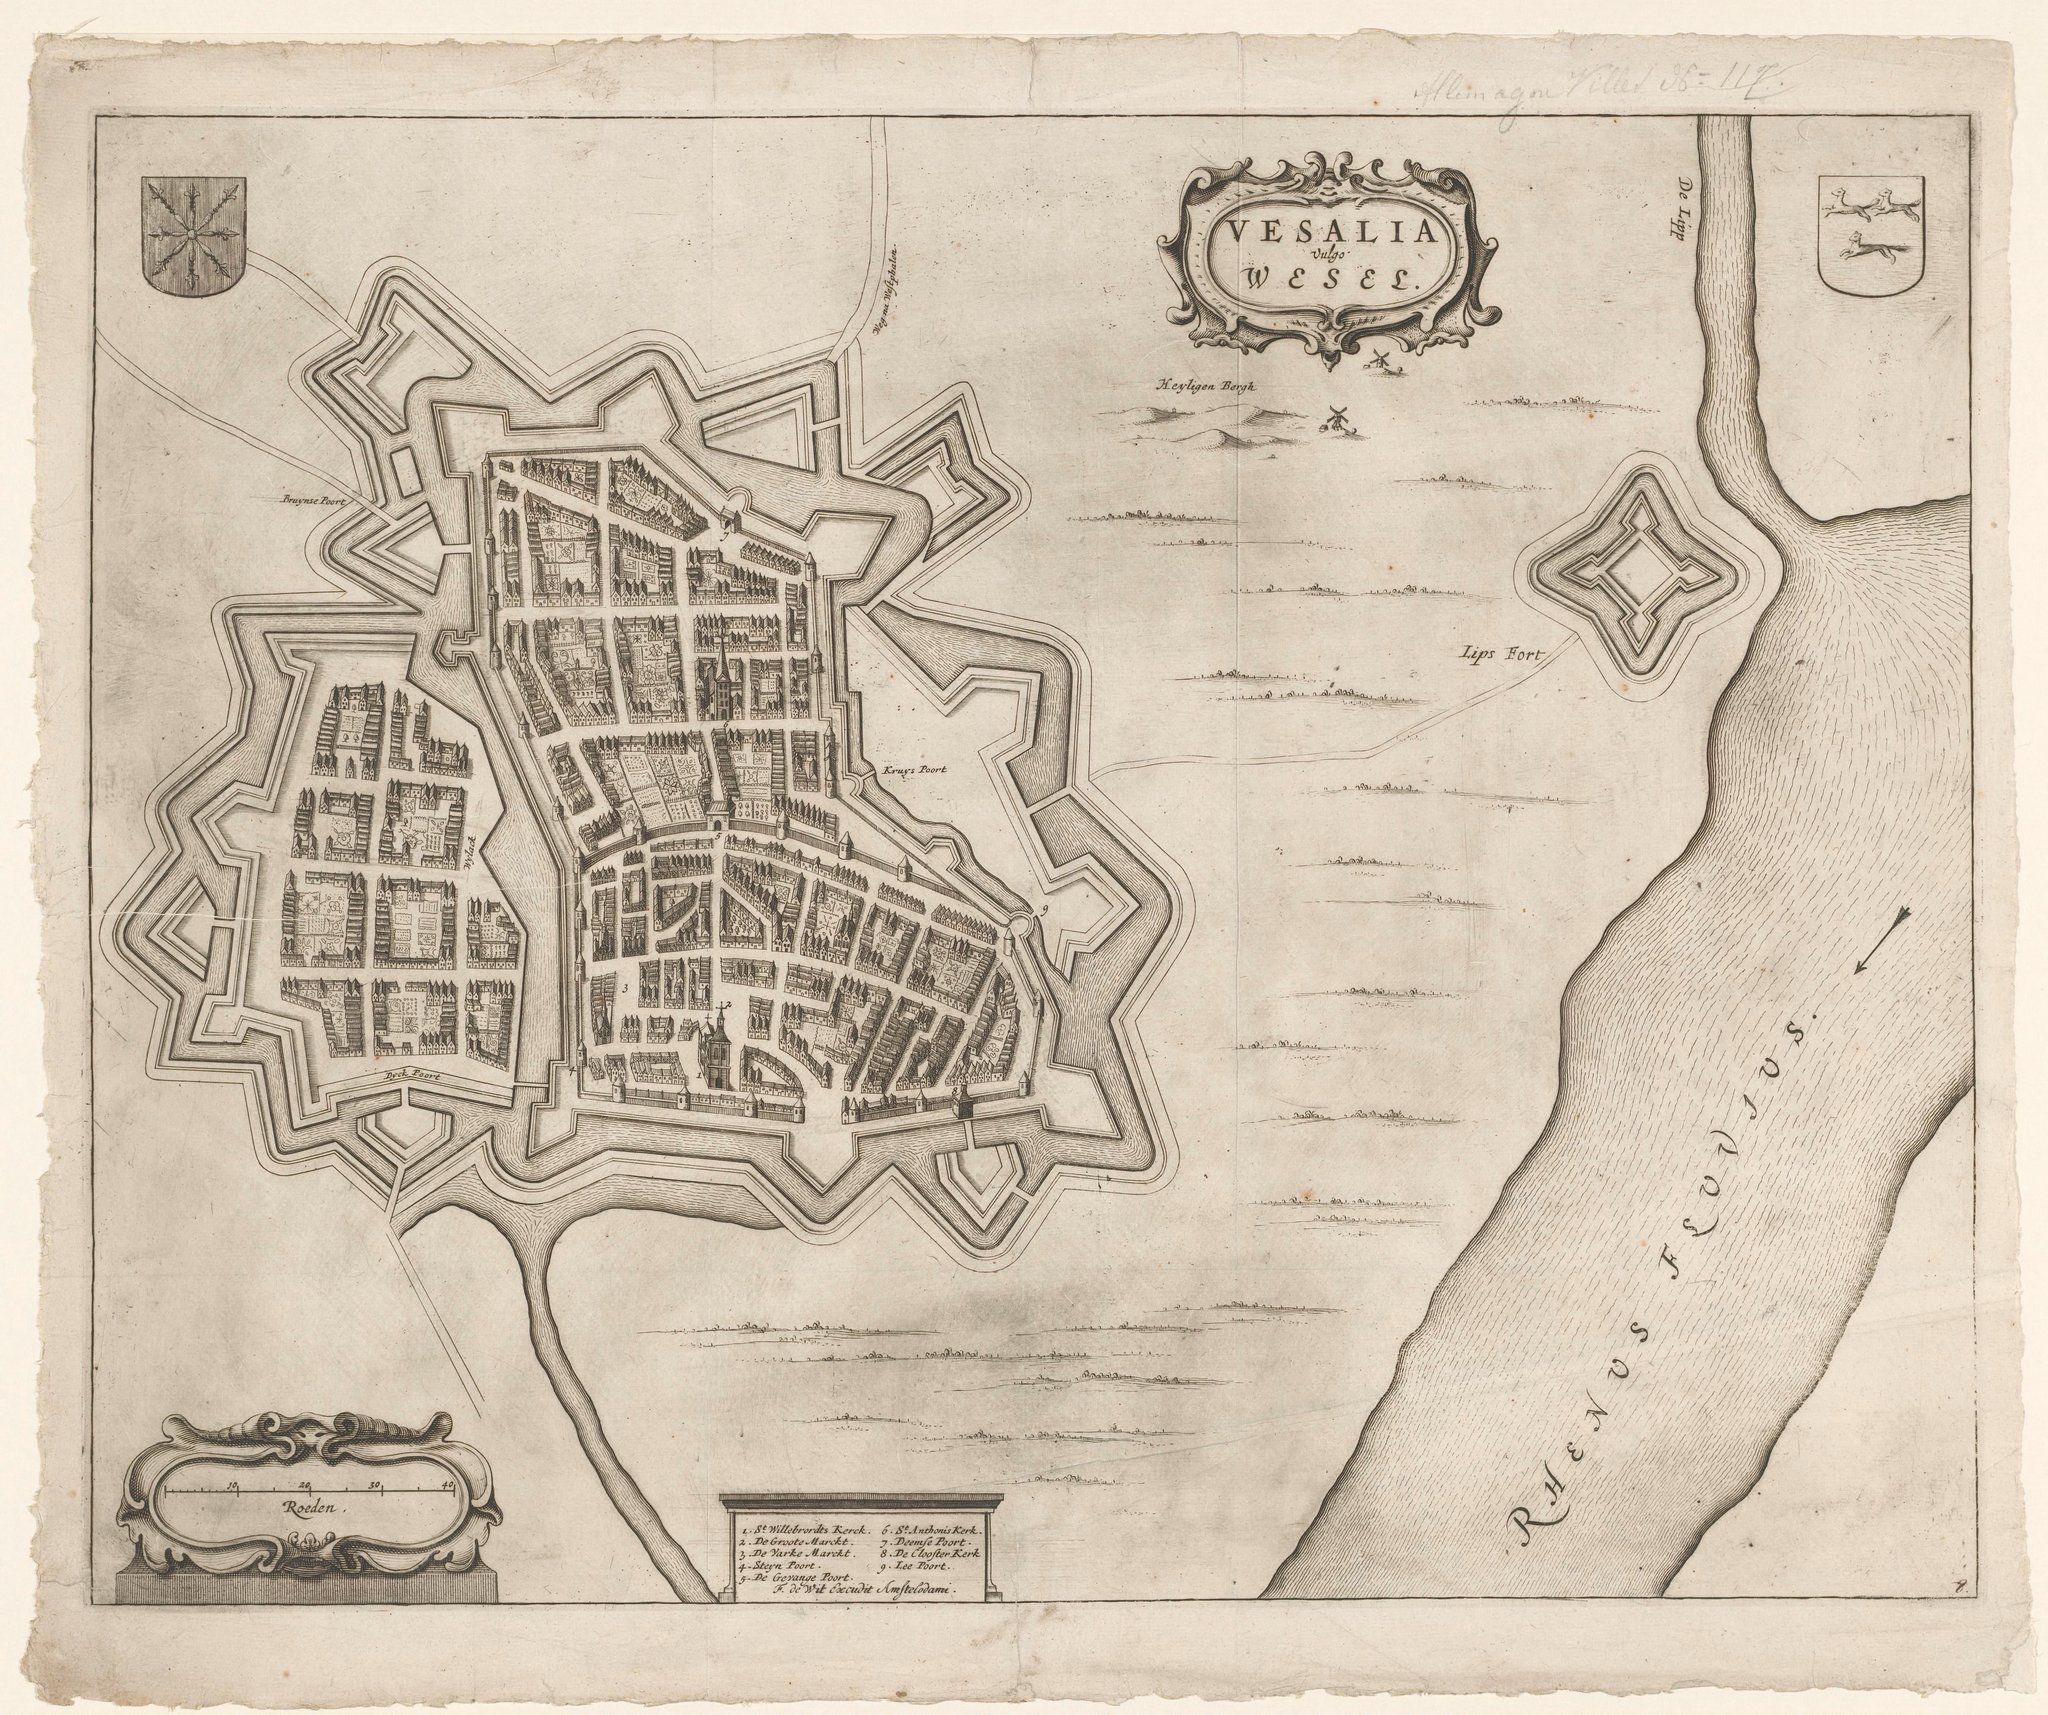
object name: print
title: Plattegrond van Wesel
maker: Anonymous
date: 1649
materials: paper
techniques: engraving, etching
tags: coat of arms (as symbol of the state, etc.) (+ city; municipal), coat of arms (as symbol of the state, etc.) (+ province; provincial), prospect of city, town panorama, silhouette of city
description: Linksboven het wapen van het hertogdom Kleef, rechtsboven het wapen van Wesel.